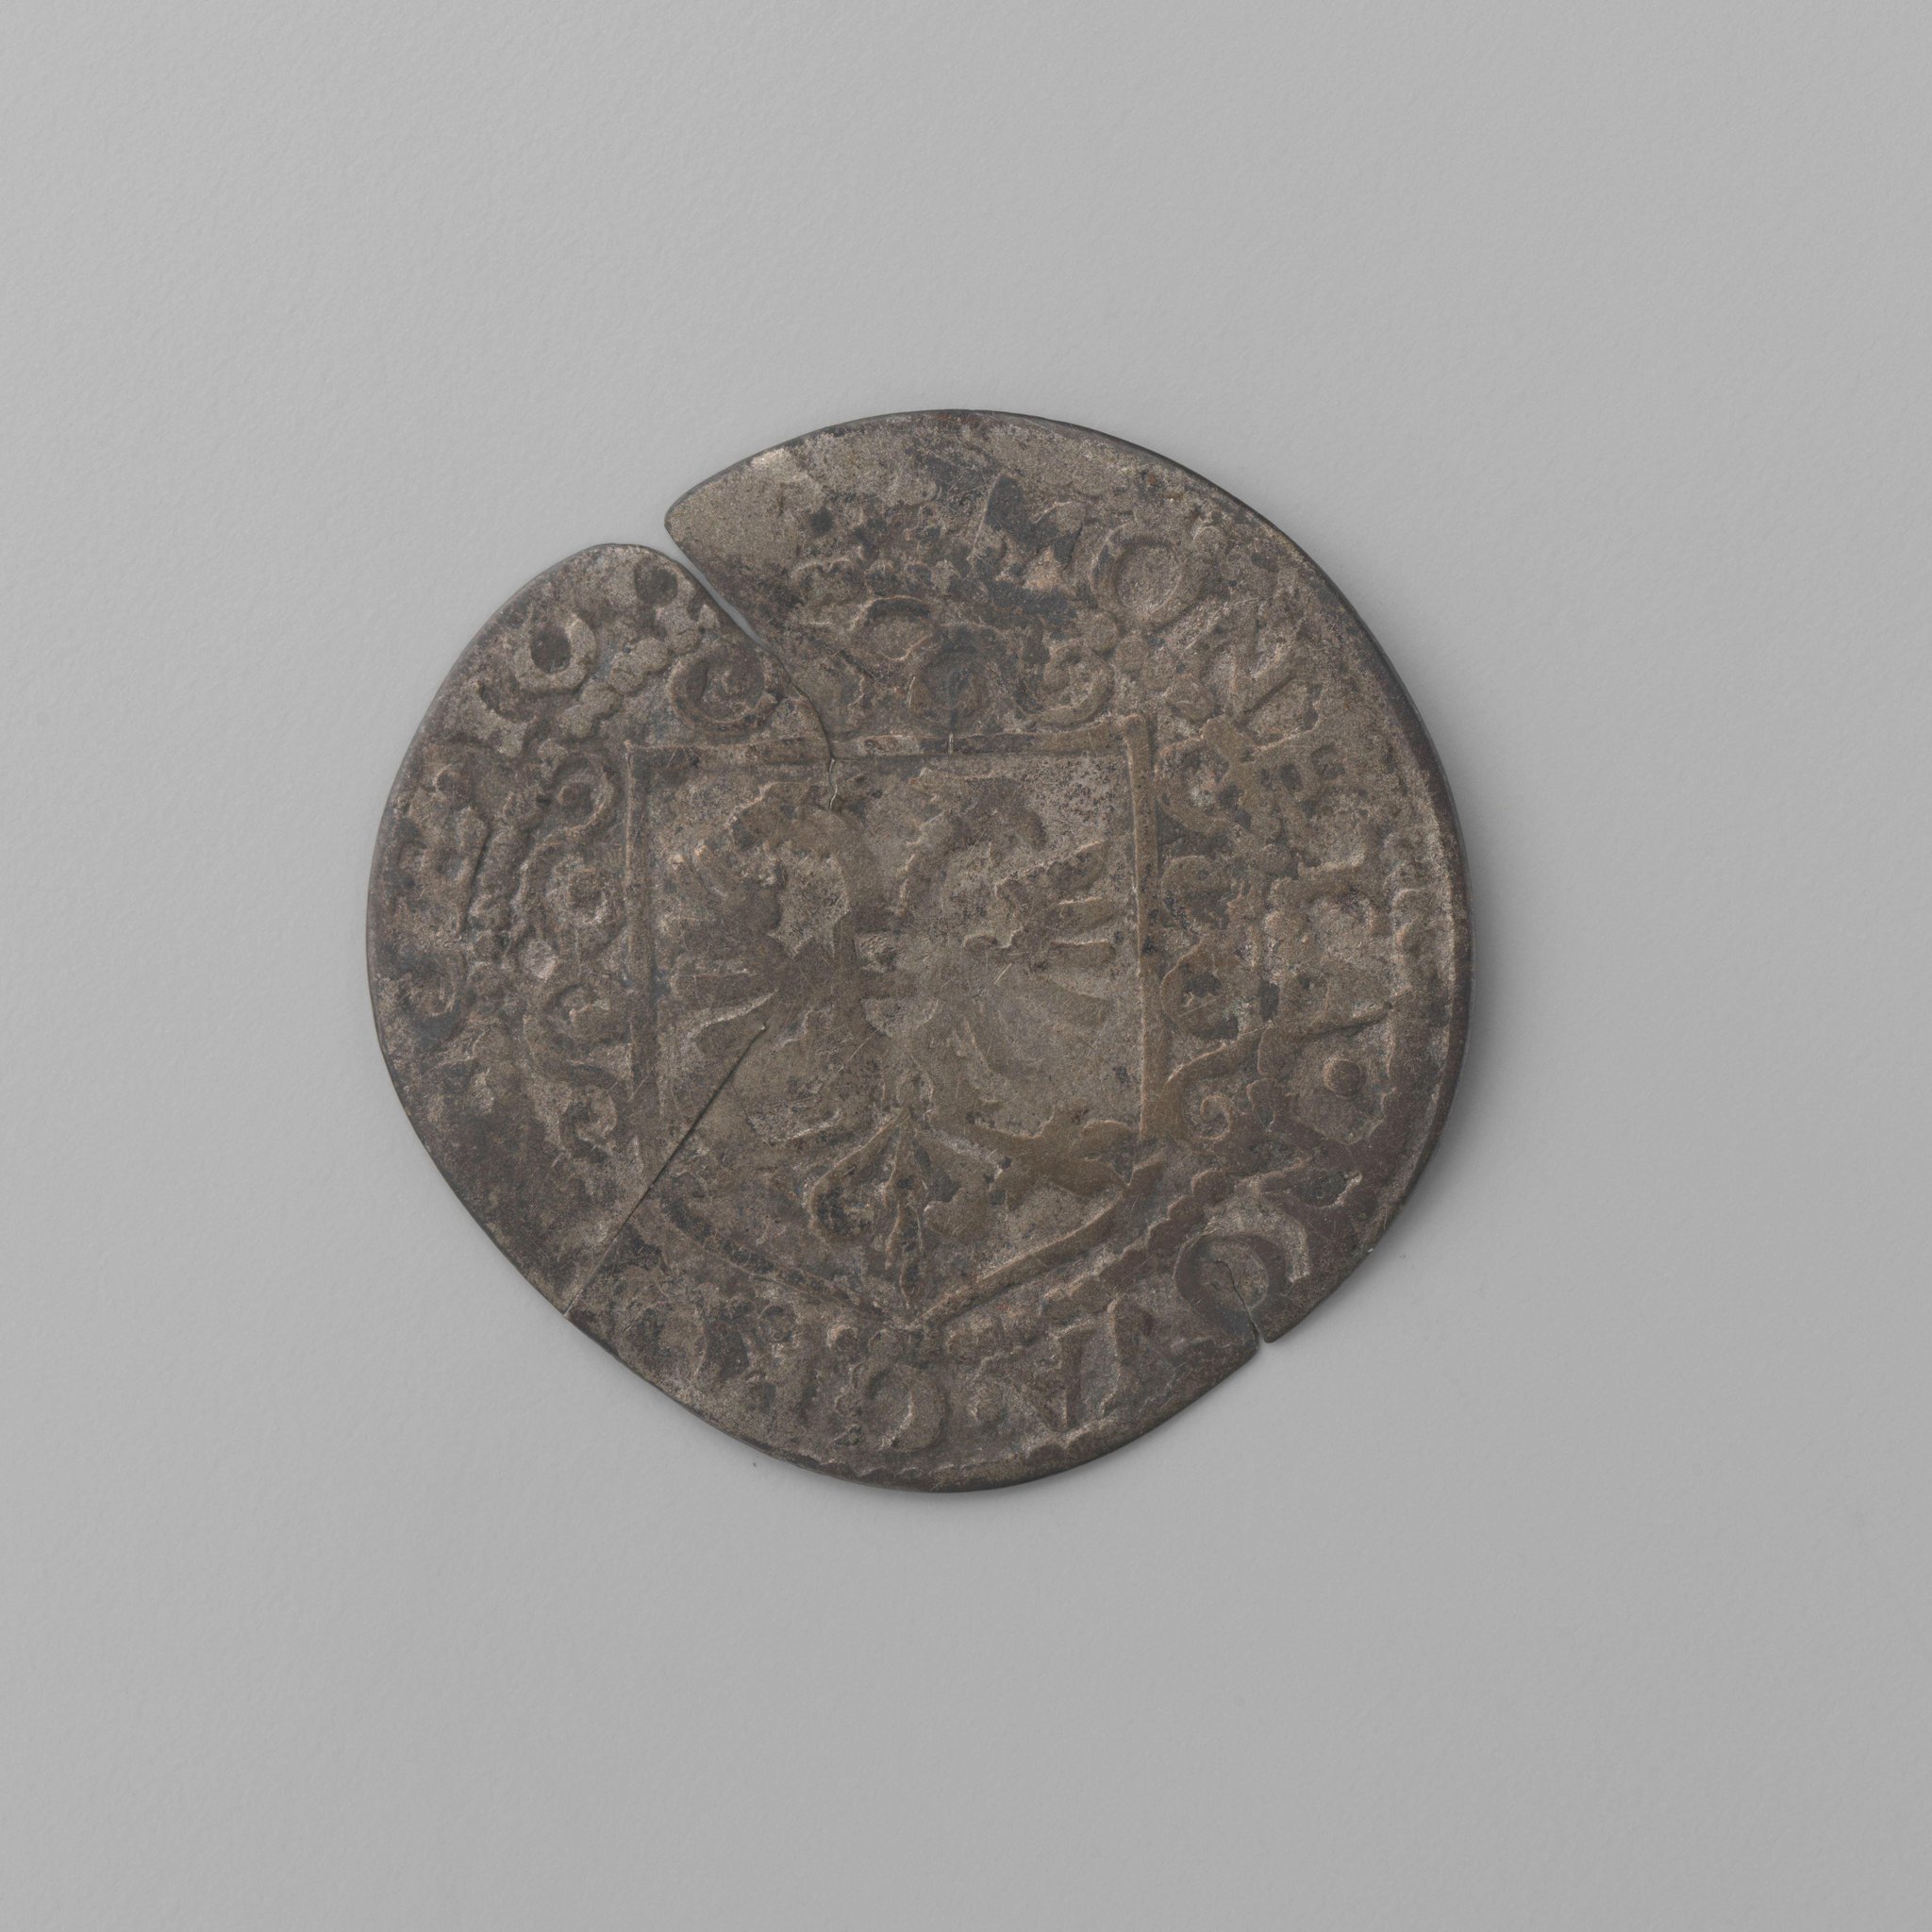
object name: coin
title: Groningse jager, 1605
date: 1605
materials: silver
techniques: striking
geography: groningen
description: Zilveren munt. Voorzijde: versierd wapenschild. Jaartal in omschrift. Keerzijde: kort gebloemd kruis, in het hart wapenschild.